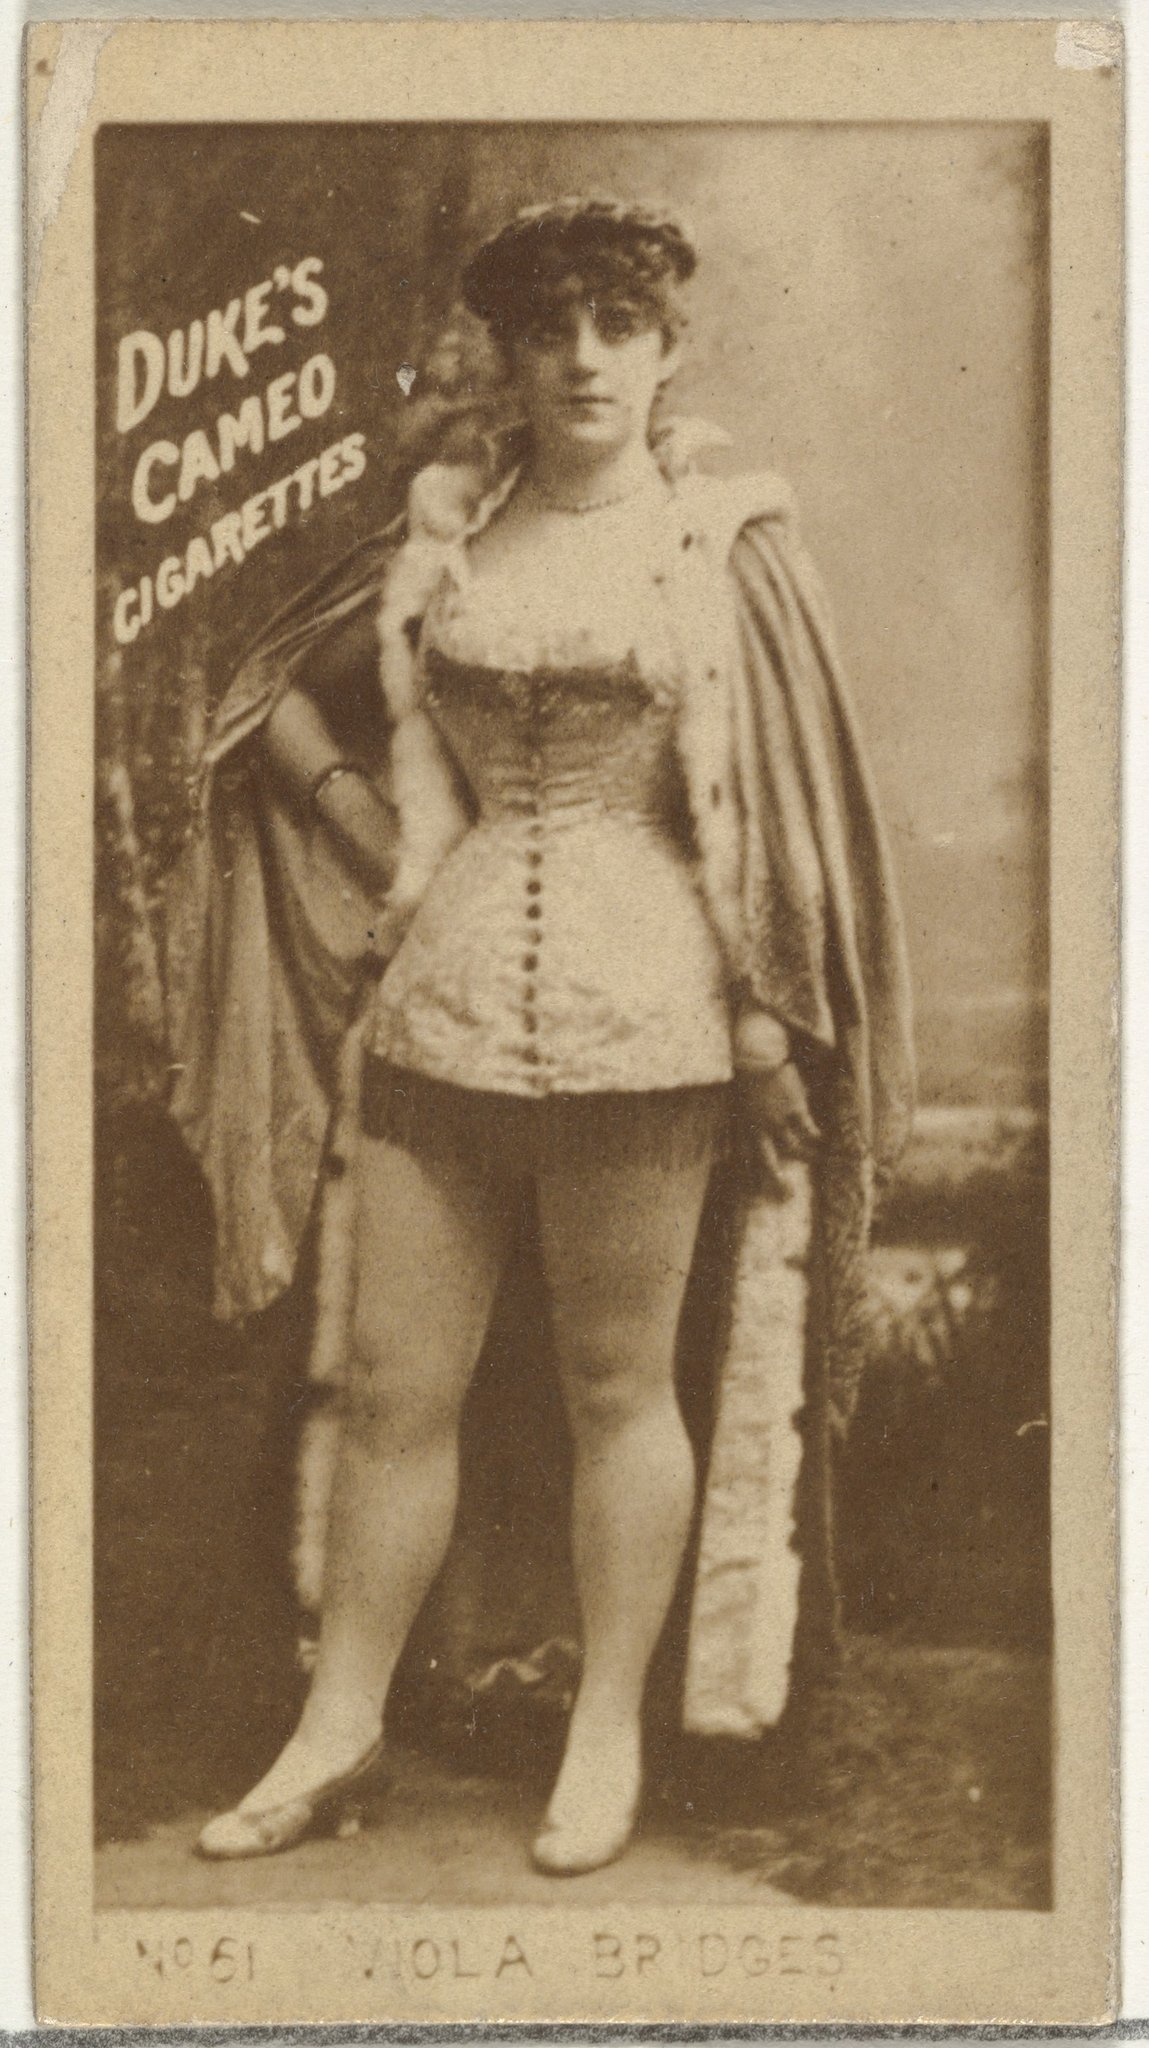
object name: photograph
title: Card Number 51, Viola Bridges, from the Actors and Actresses series (N145-4) issued by Duke Sons & Co. to promote Cameo Cigarettes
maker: w. duke, sons & co.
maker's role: publisher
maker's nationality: american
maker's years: 1870-1920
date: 1880-1889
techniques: albumen silver print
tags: portraits,women,actresses